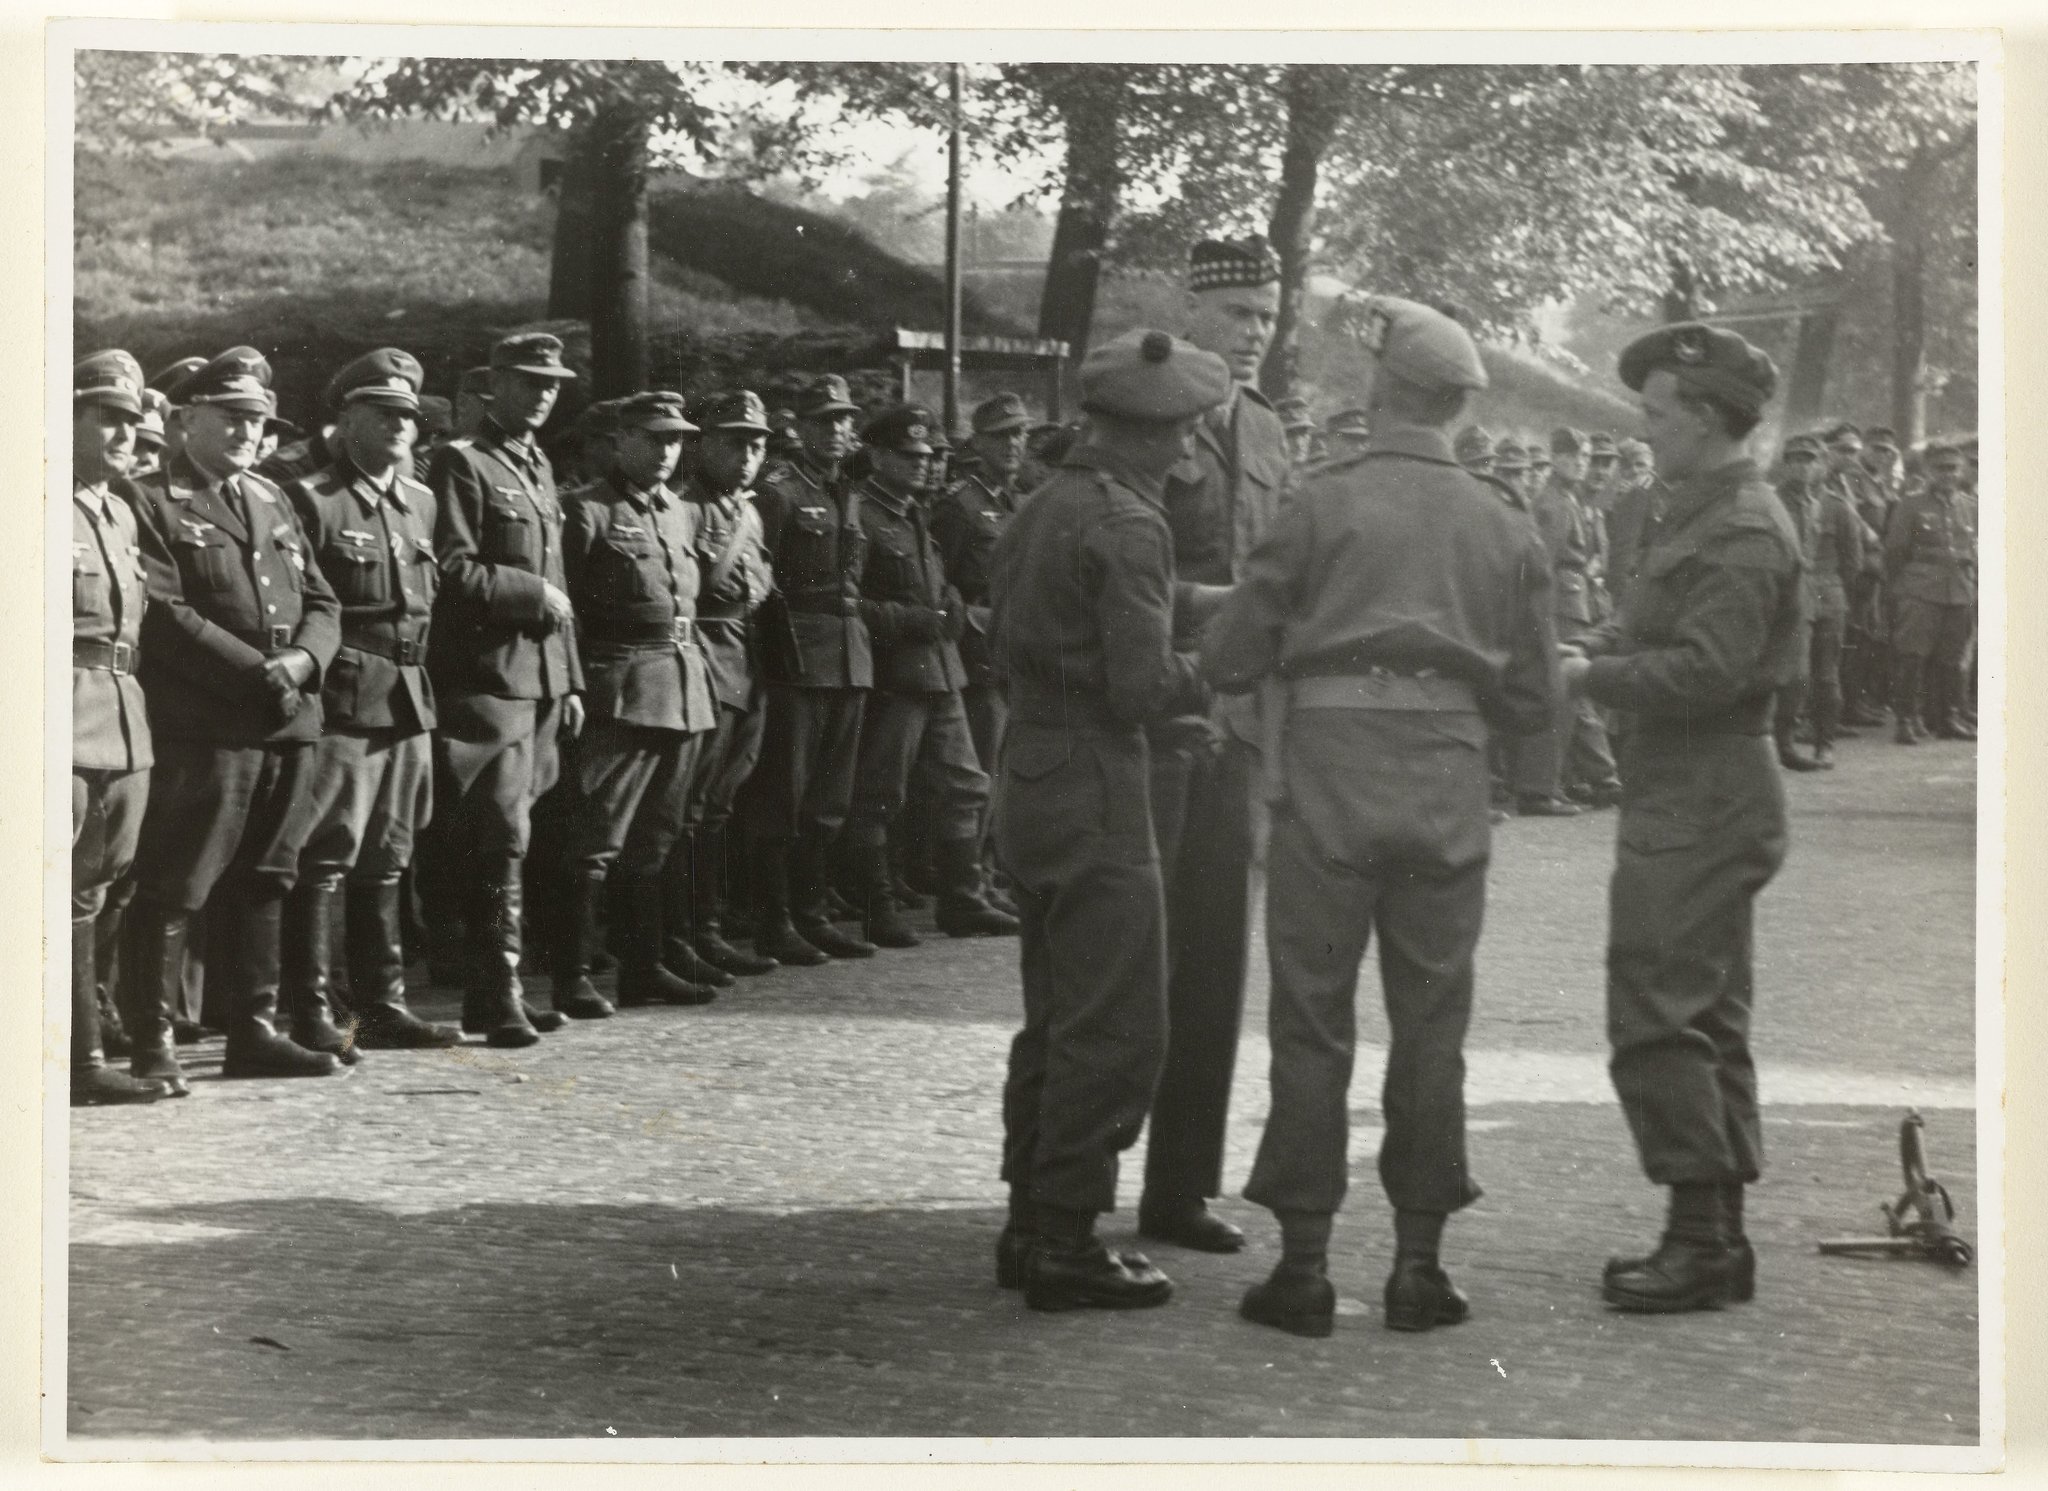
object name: photograph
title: Krijgsgevangen Duitsers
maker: Anonymous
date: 1905-1945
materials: photographic support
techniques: photography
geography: netherlands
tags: prisoner of war (after the battle), netherlands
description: Duitse krijgsgevangenen bewaakt door Engelse? militairen.Op de voorgrond 4 geallieerde militairen. Achter in een rij de Duitse krijgsgevangenen.